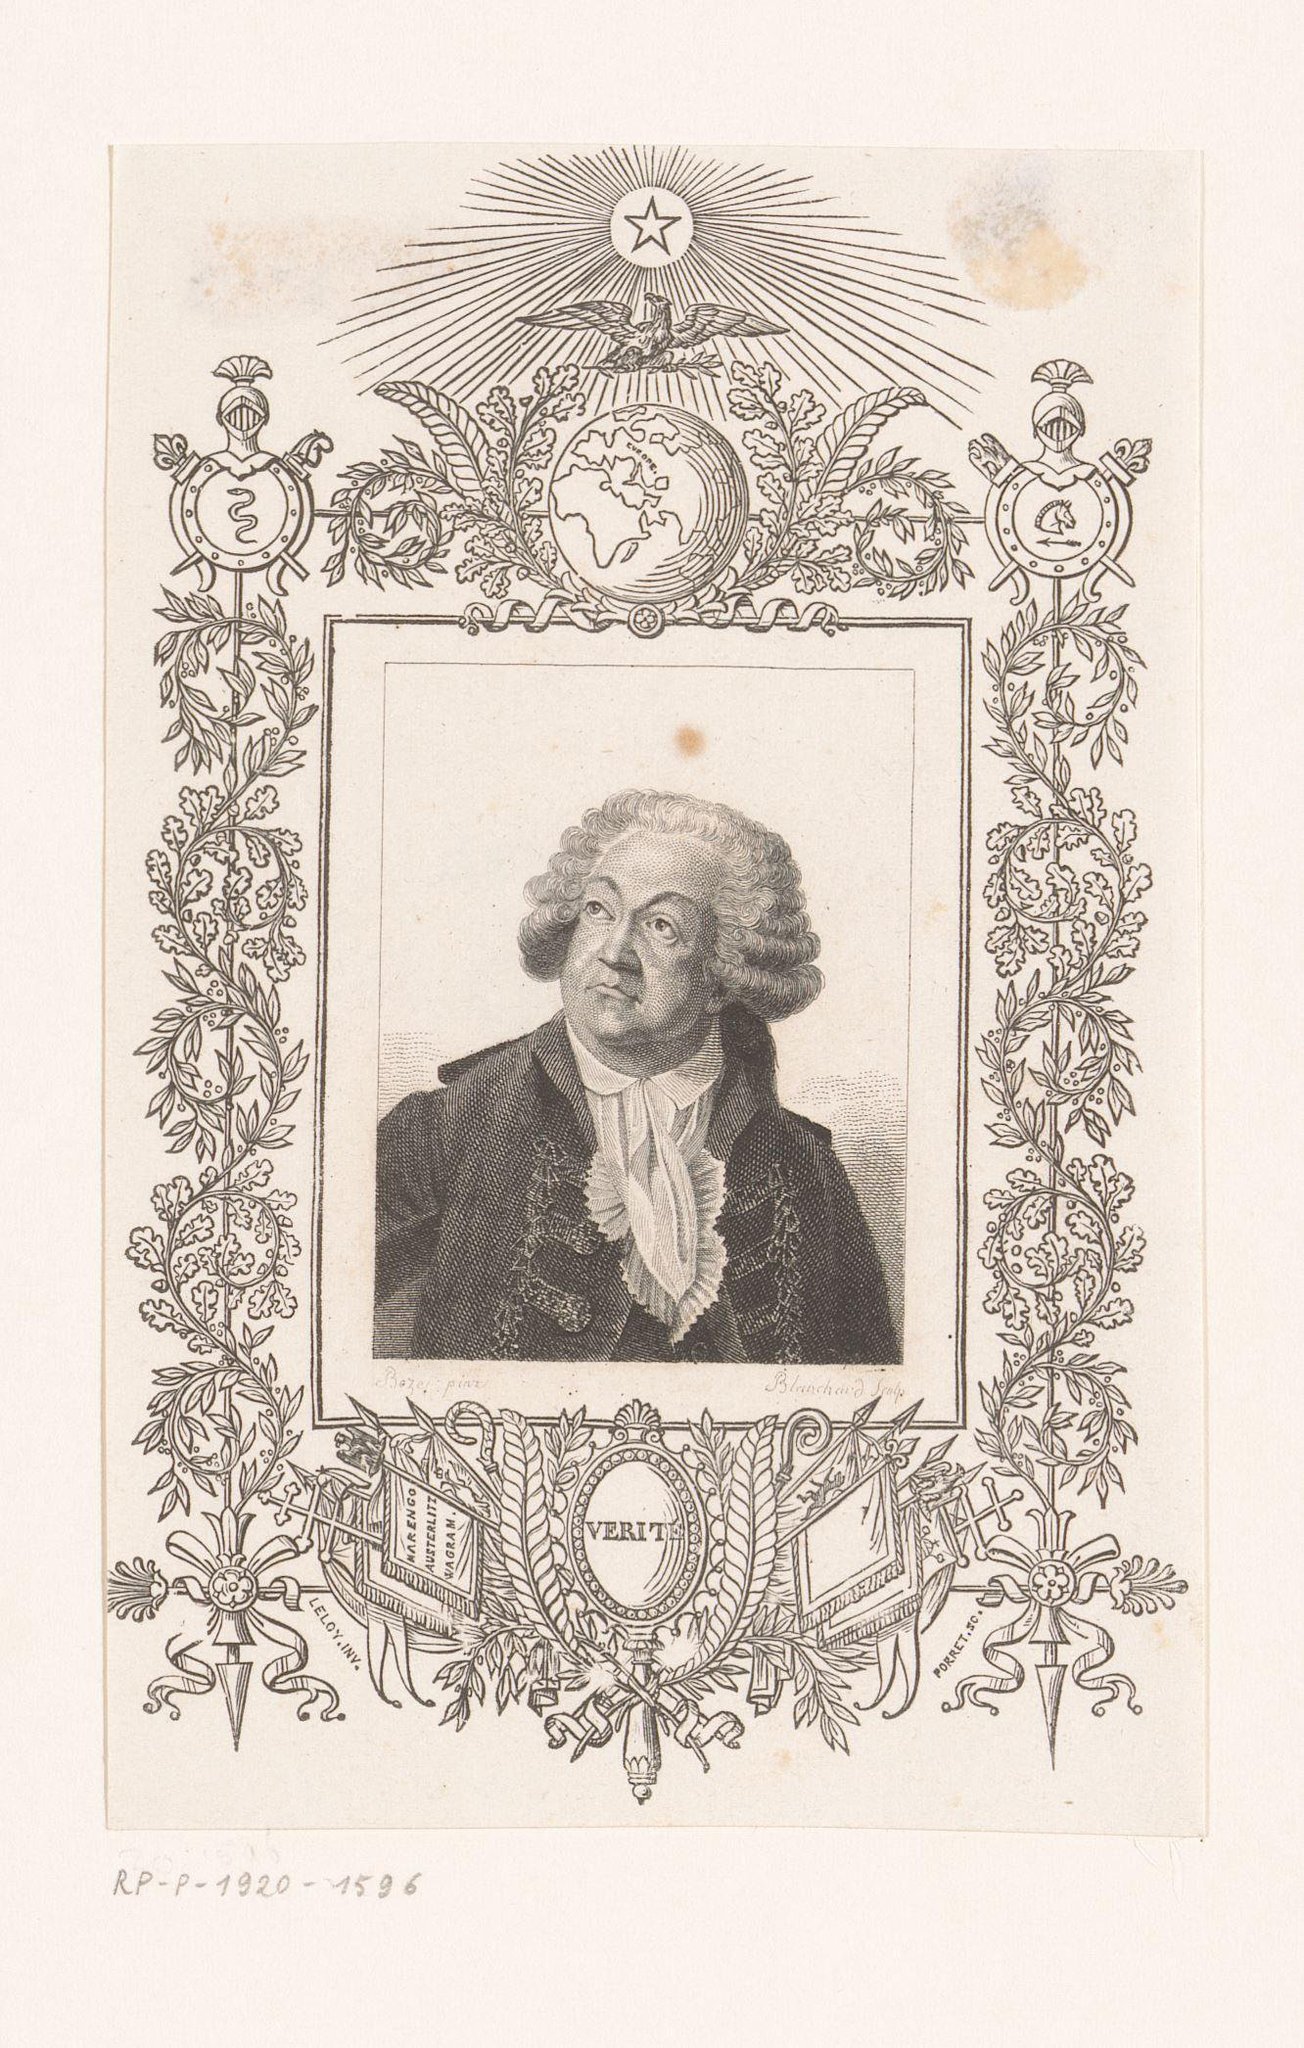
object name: print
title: Portret van Honoré Gabriel de Riqueti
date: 1802-1898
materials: paper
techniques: engraving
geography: france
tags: paris, honoré-gabriel de riqueti (graaf van mirabeau), historical persons, ornament ~ cartouche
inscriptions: collector's mark: Lugt 2228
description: Dit portret maakte deel uit van de serie "Galerie Napoléon", een collectie van honderd portretten van vooraanstaande figuren uit de omgeving van Napoleon Bonaparte. De serie werd uitgegeven door Bénard in Parijs in 1829-30.